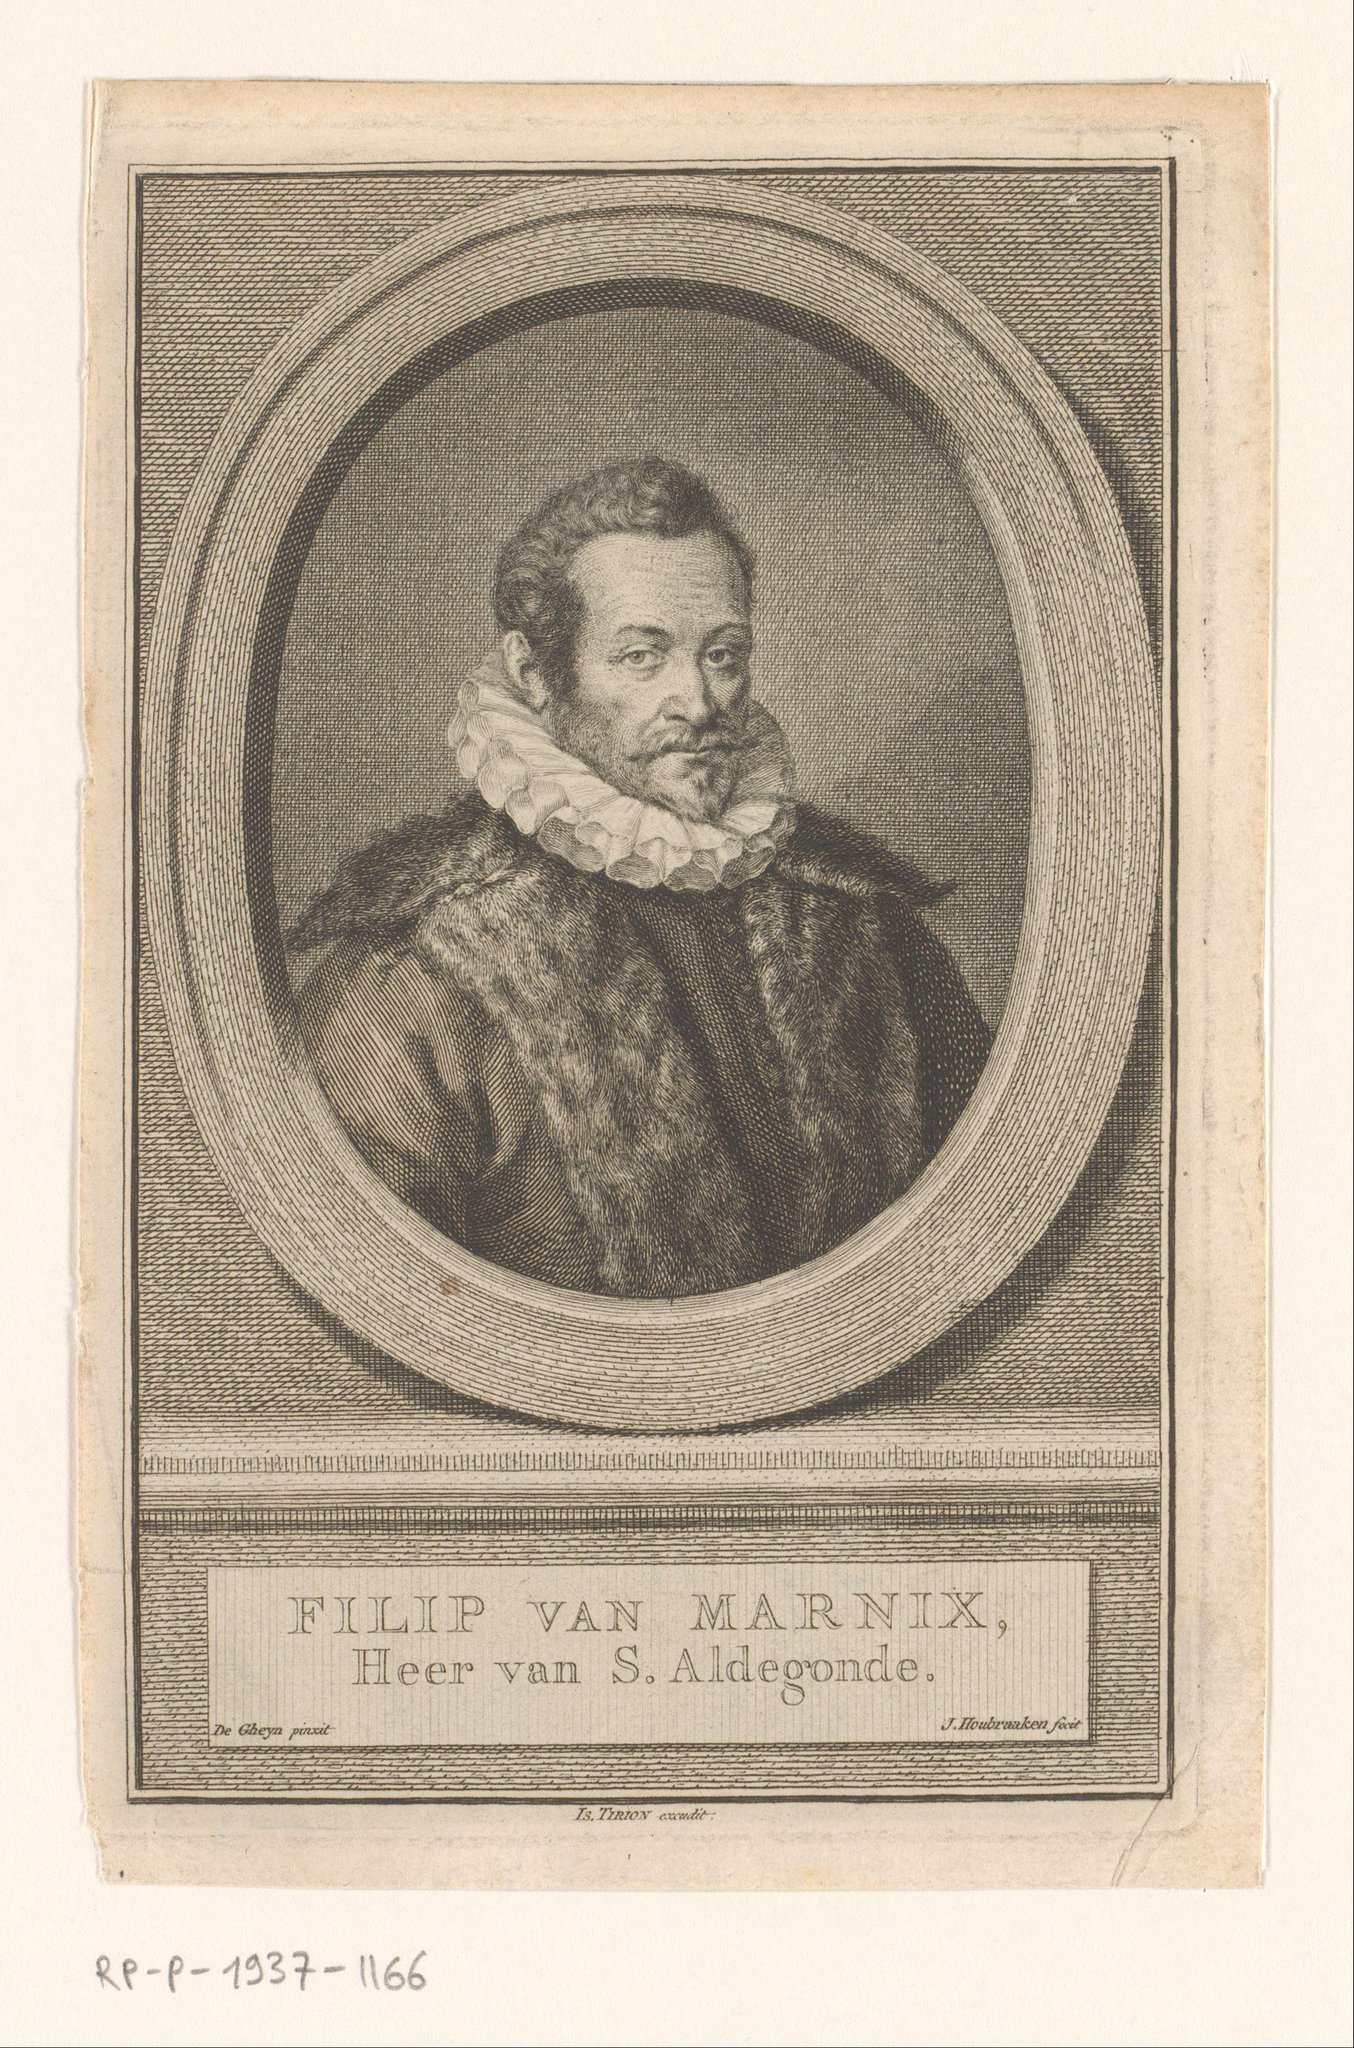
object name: book illustration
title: Portret van Filips van Marnix, heer van Sint-Aldegonde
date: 1752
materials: paper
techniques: engraving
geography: amsterdam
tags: brussels, leiden, politician, filips van marnix van sint-aldegonde, ornament ~ medallion, historical persons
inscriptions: collector's mark: Lugt 2228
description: Prent waarschijnlijk uit: Wagenaar, Jan. Vaderlandsche historie, vervattende de geschiedenissen der nu Vereenigde Nederlanden, inzonderheid die van Holland (...). Amsterdam: Isaak Tirion, 1752, dl. 7. Latere staat is gebruikt in de editie uit 1792 van 'Vaderlandsche historie (...)'.